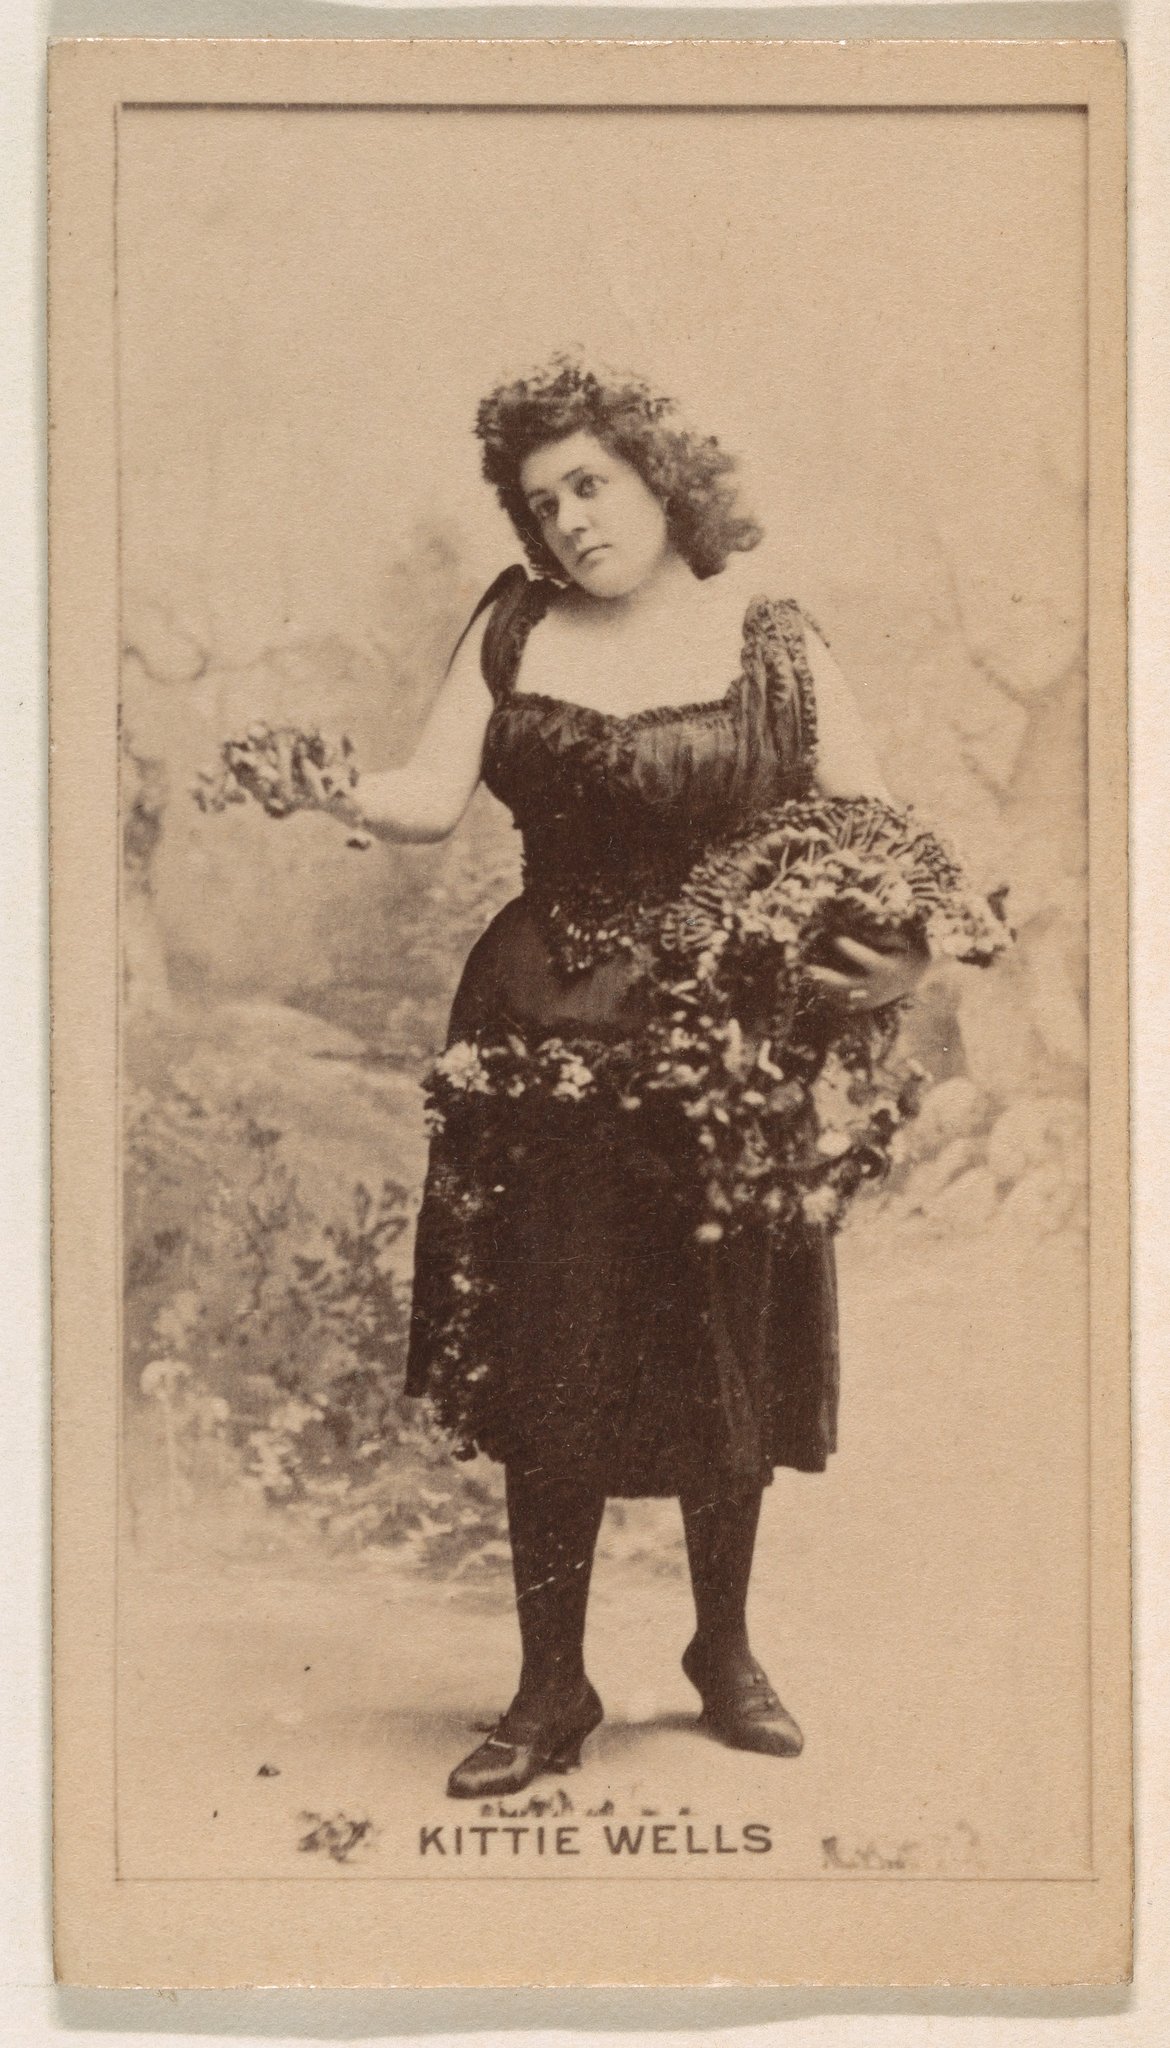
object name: photograph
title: Kittie Wells, from the Actresses series (N245) issued by Kinney Brothers to promote Sweet Caporal Cigarettes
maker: kinney brothers tobacco company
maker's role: publisher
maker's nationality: american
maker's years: 1869-2011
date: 1890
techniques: albumen silver print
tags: portraits,women,actresses